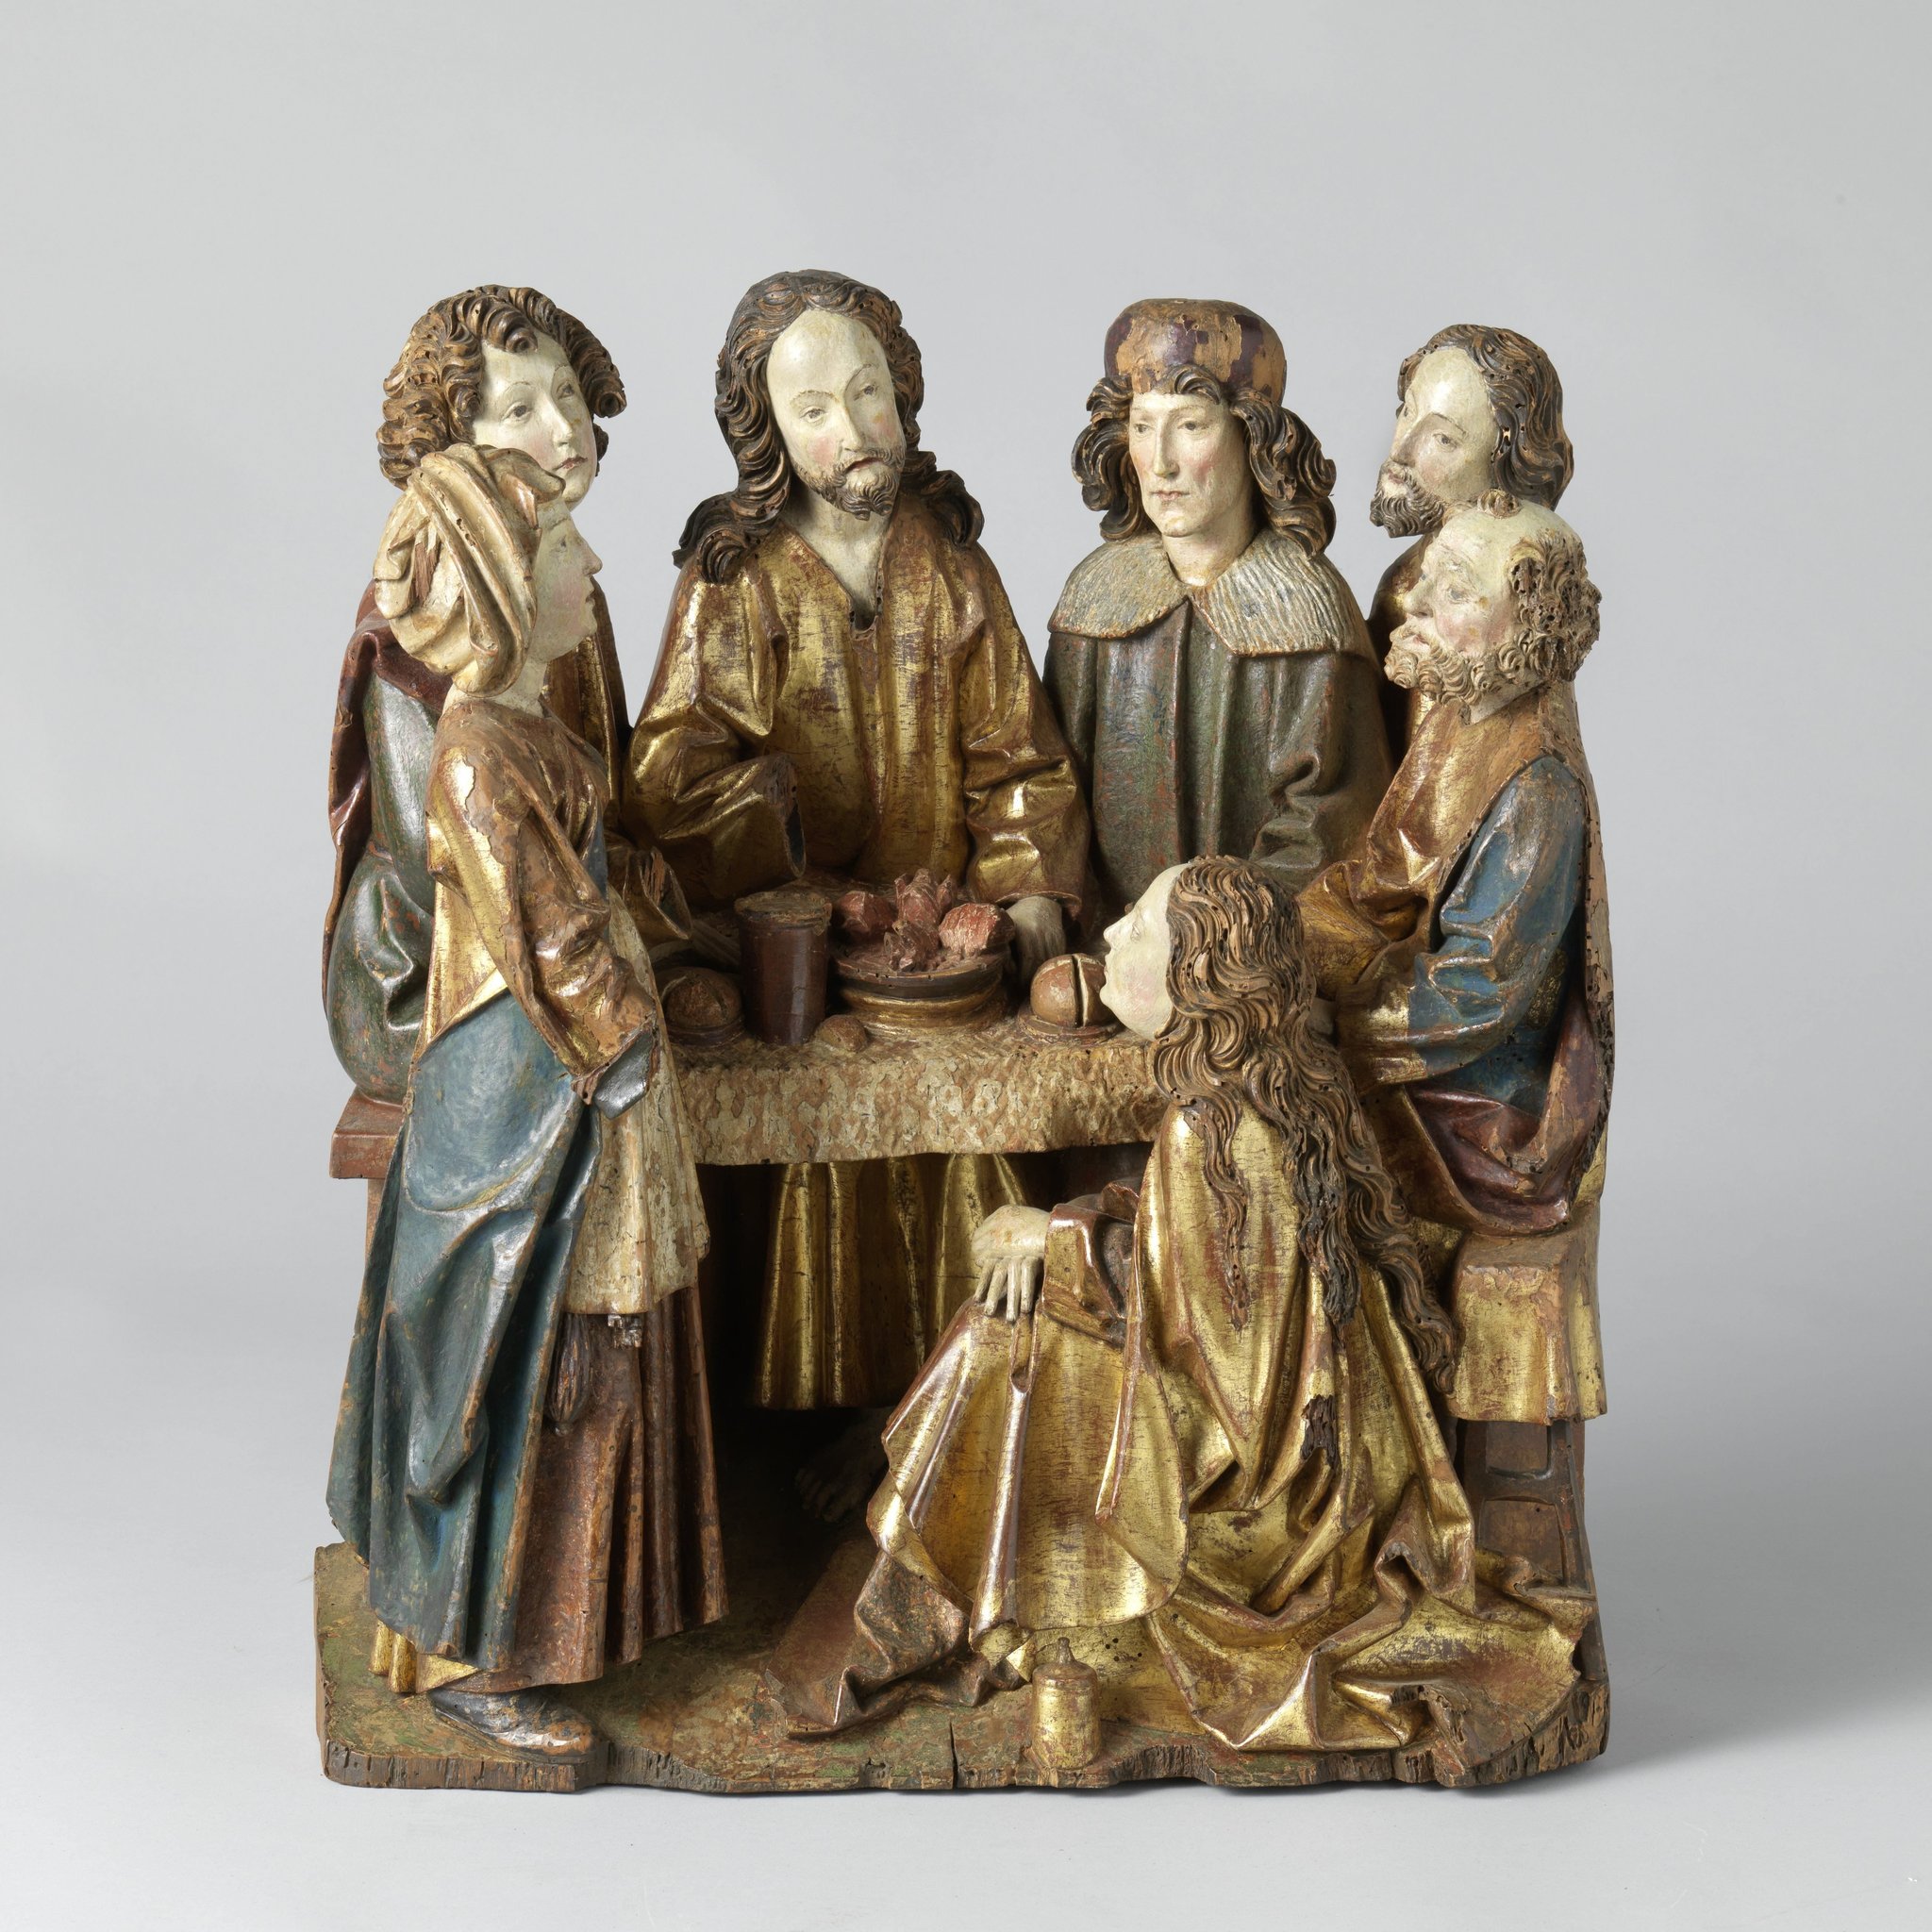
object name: sculpture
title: Christ in the House of Mary and Martha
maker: Anonymous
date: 1520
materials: wood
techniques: gilding, polychromy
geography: ulm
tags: christ in the house of martha and mary (luke 10:38-42)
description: These three groups depict scenes from the life of Christ in which he appears at a meal table. They would originally have formed part of the predella (lower zone) of a large carved altar. The three table scenes refer to the celebra-tion of Mass, when bread and wine are presented at the altar as the body and blood of Christ.